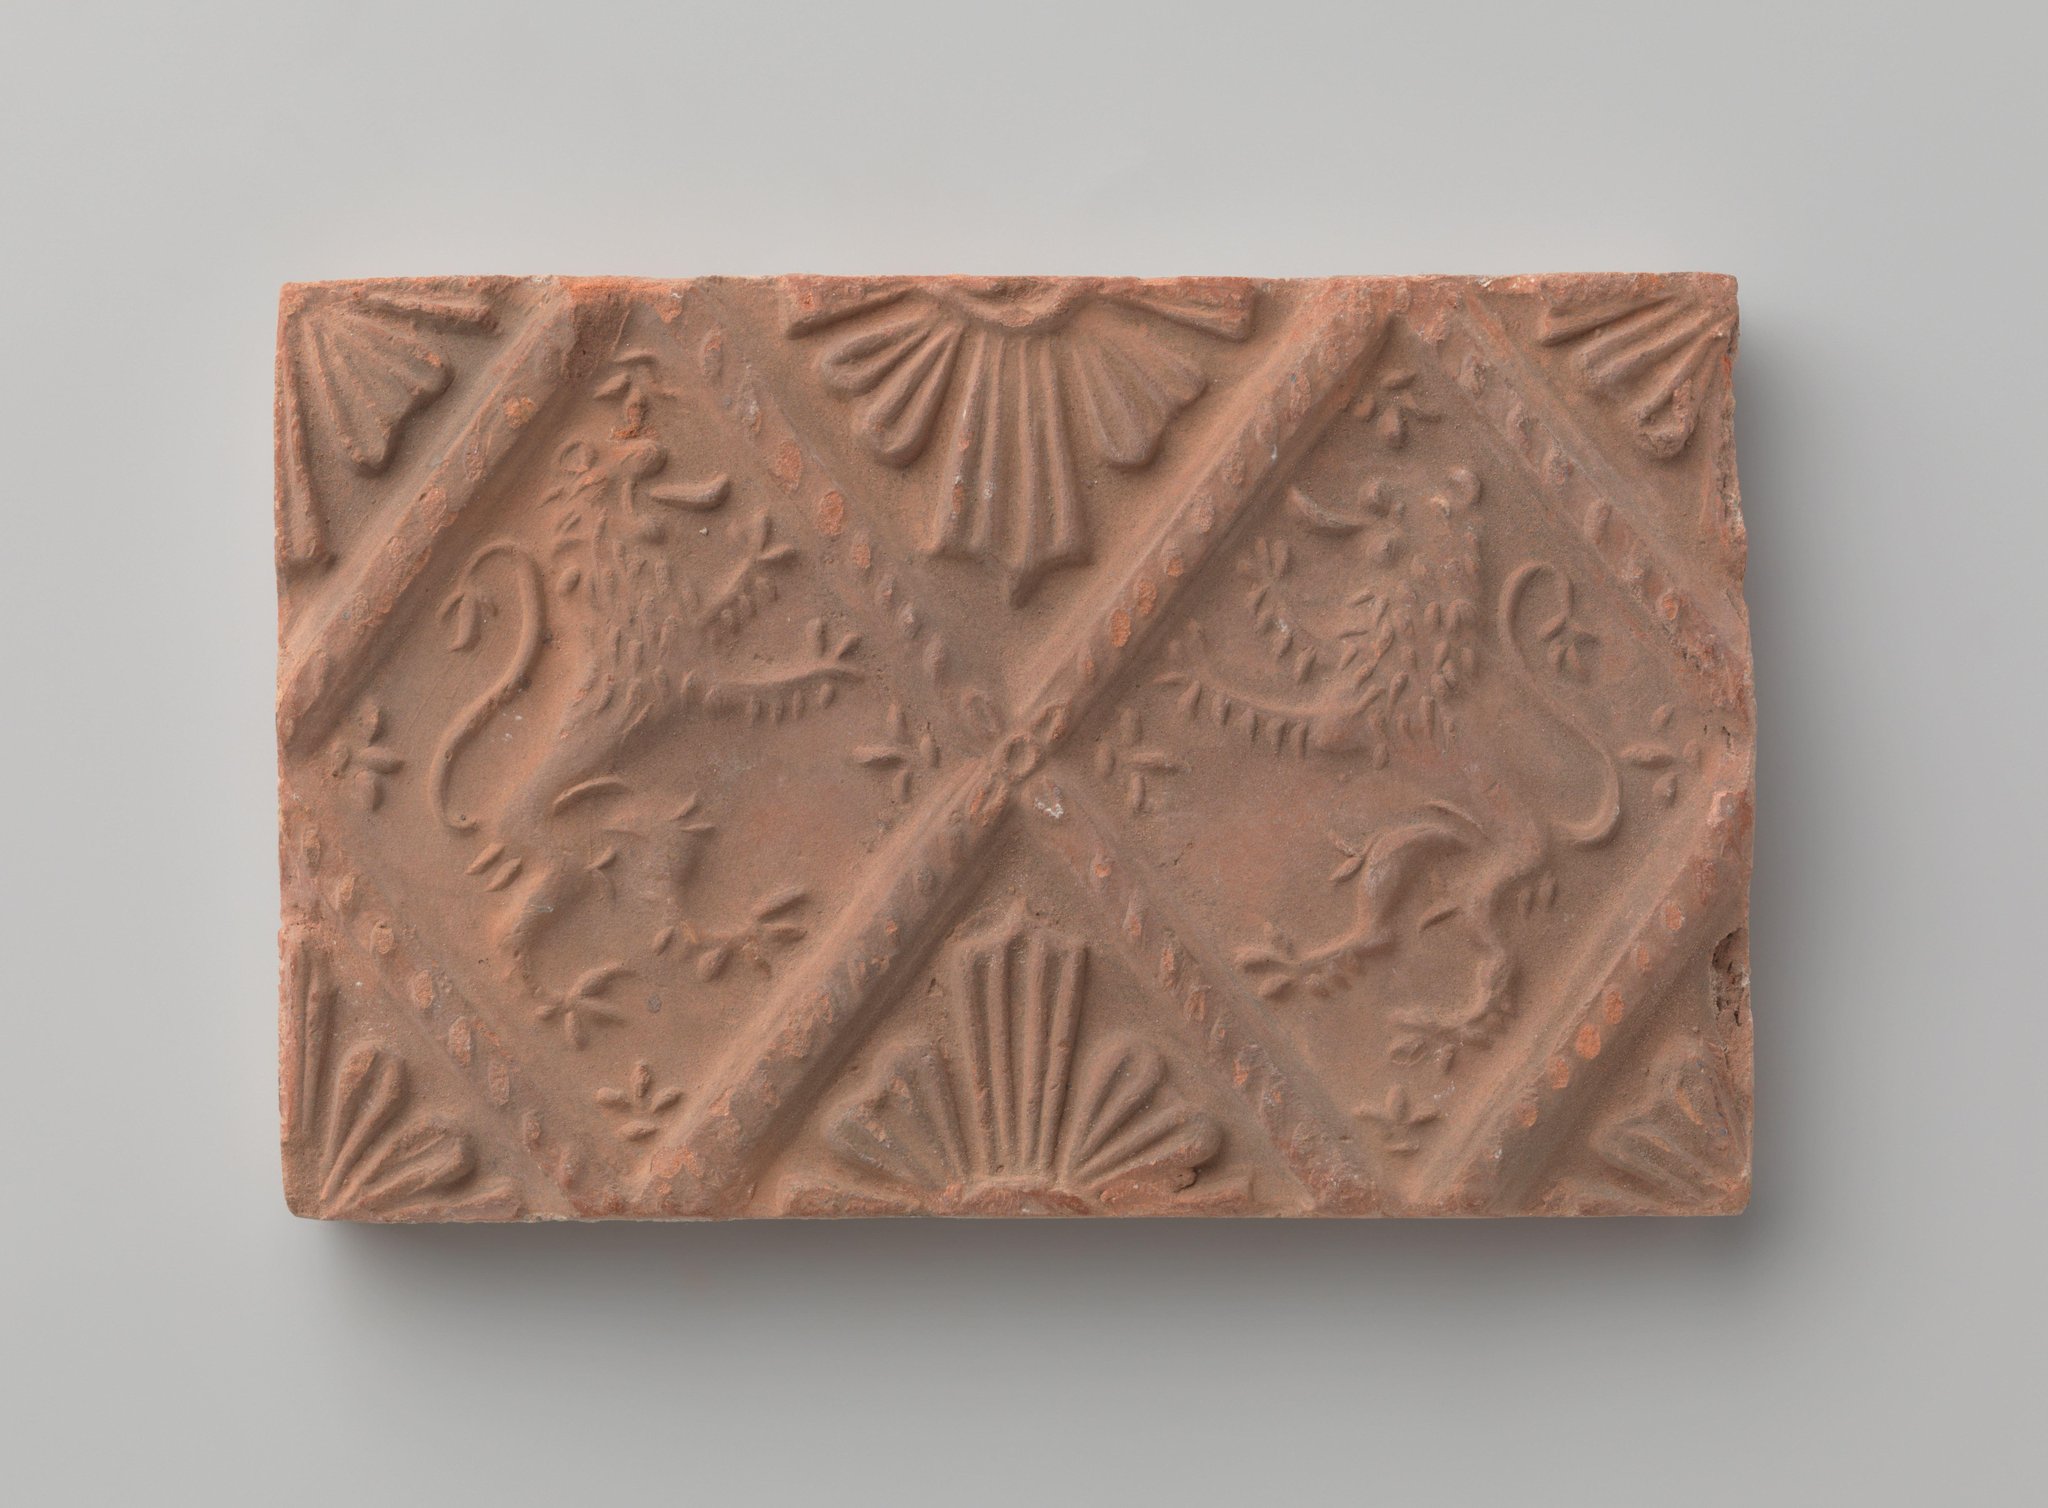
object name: hearthstone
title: Haardsteen met voorstelling van twee klimmende leeuwen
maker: Anonymous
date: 1875-1900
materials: earthenware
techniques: printing, firing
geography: netherlands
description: Haardsteen met voorstelling van twee klimmende leeuwen, geplaatst in geprofileerde ruit. De halve ruiten aan de boven- en onderkant zijn opgevuld met stermotief.